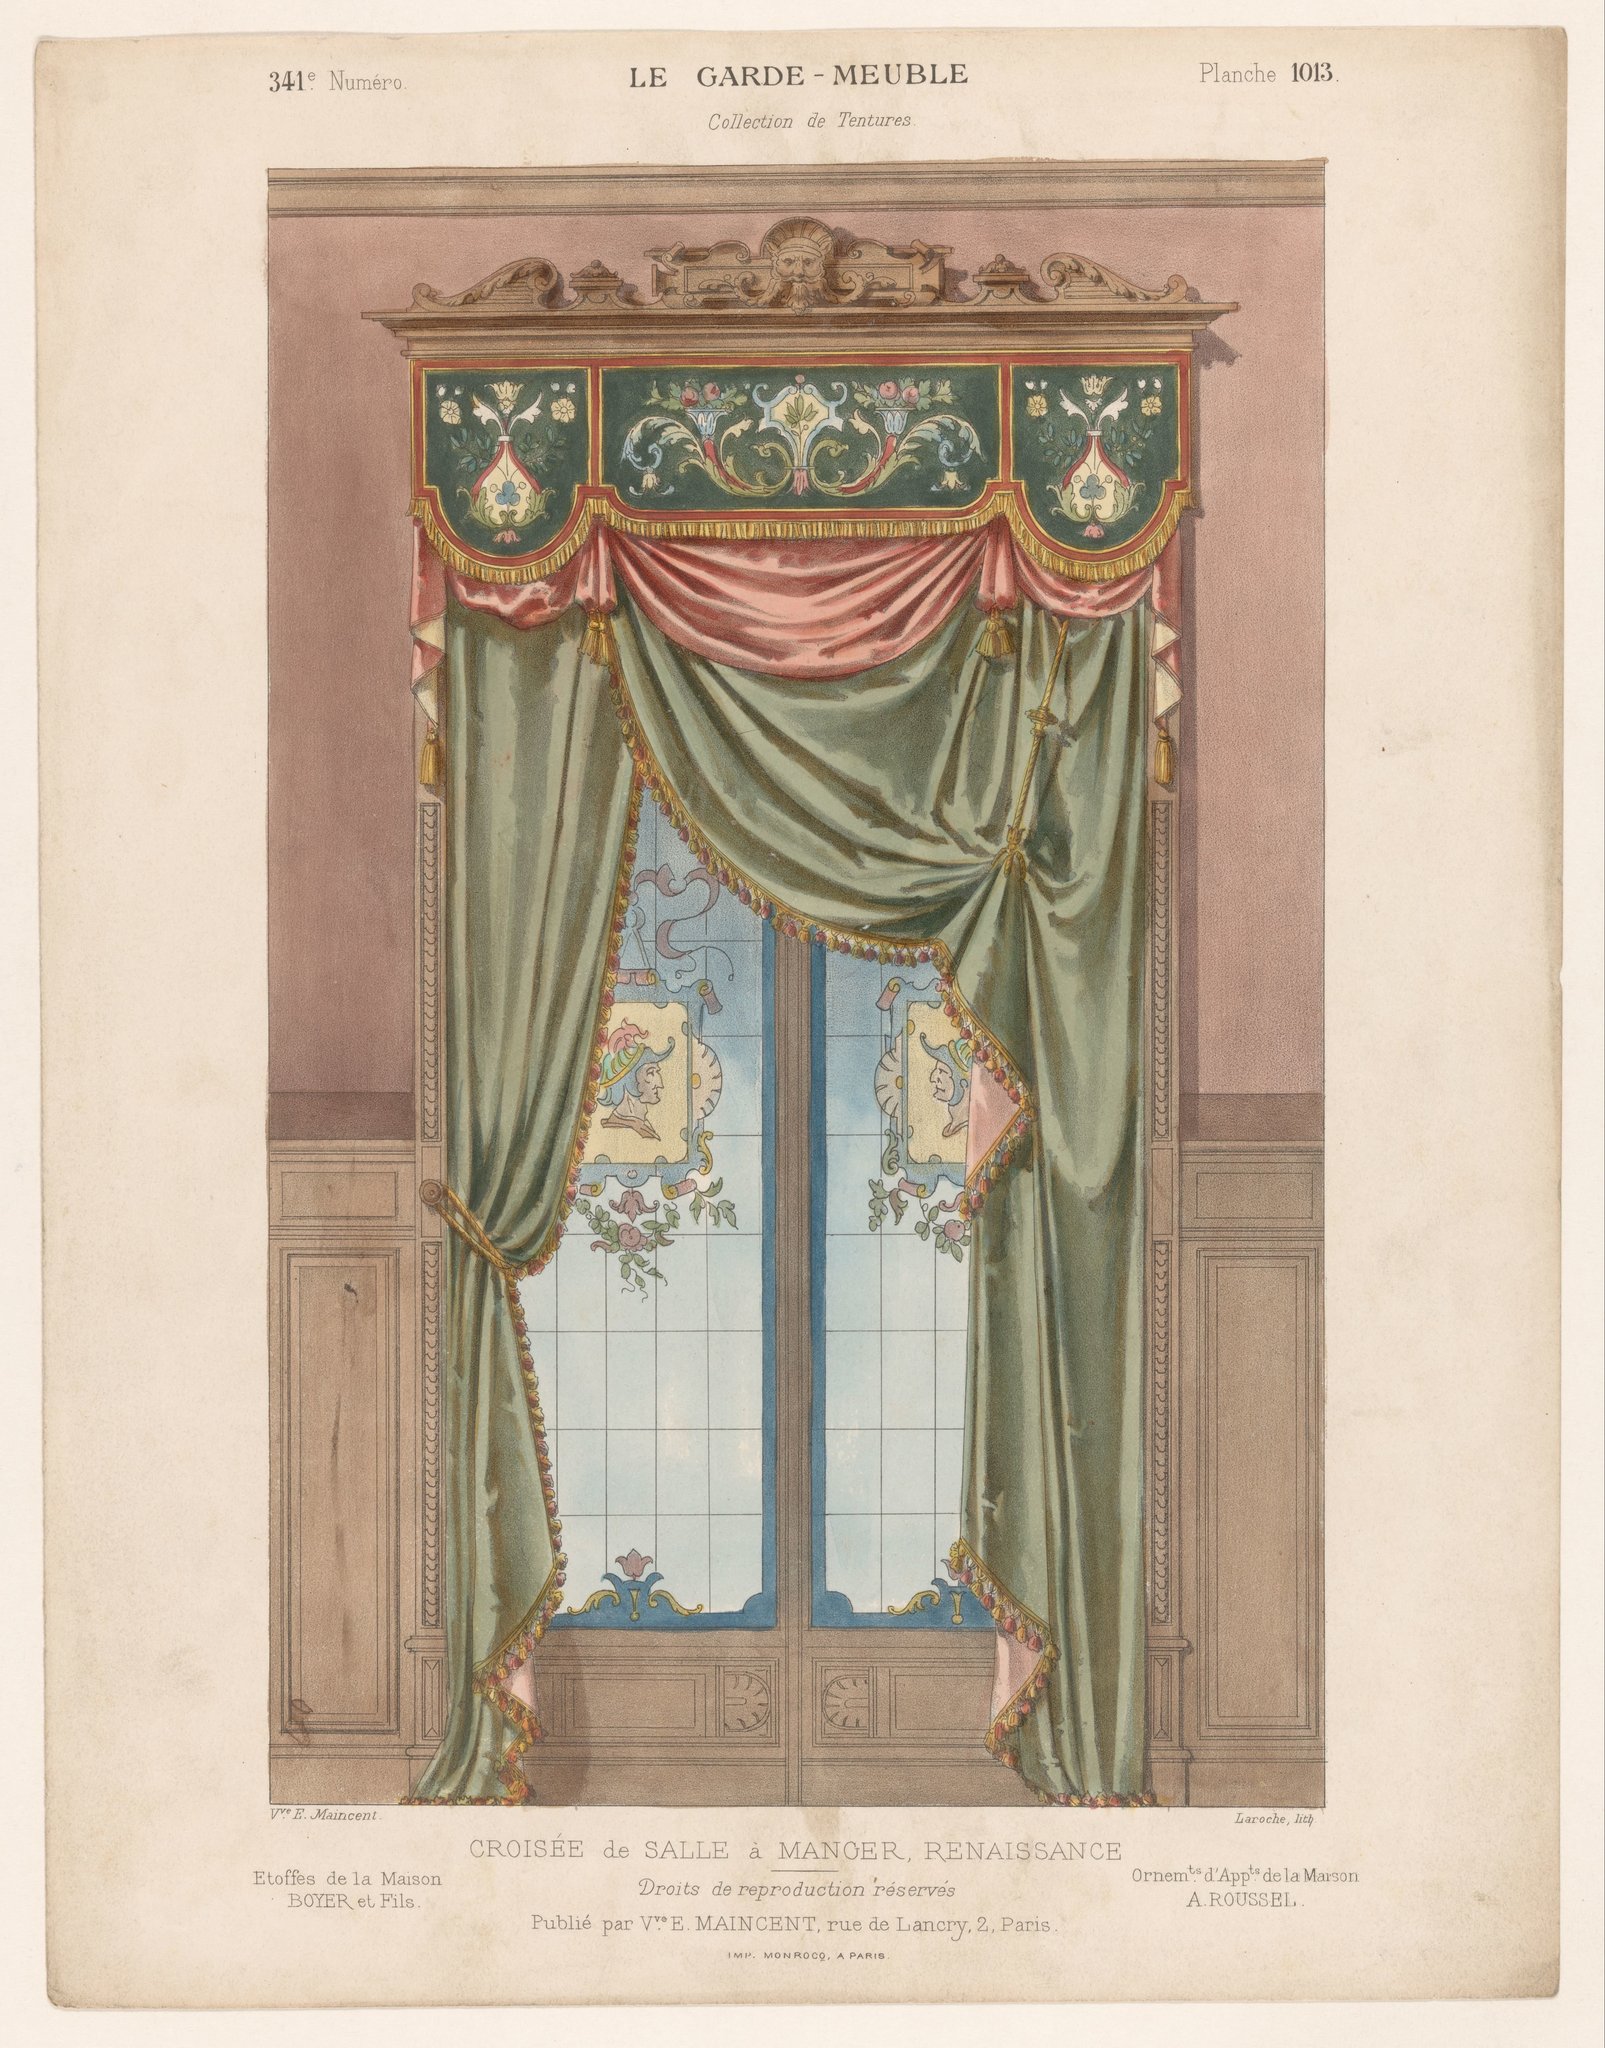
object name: print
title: Le Garde-Meuble / Collection de Tentures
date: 1895-1910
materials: paper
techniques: hand coloring, lithograph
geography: paris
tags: window, hangings and drapery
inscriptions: : ‘Droits de reproduction réservés.’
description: Kruisvenster van de eetkamer met gedrapeerde gordijnen in renaissancestijl. Prent uit 341e Livraison.